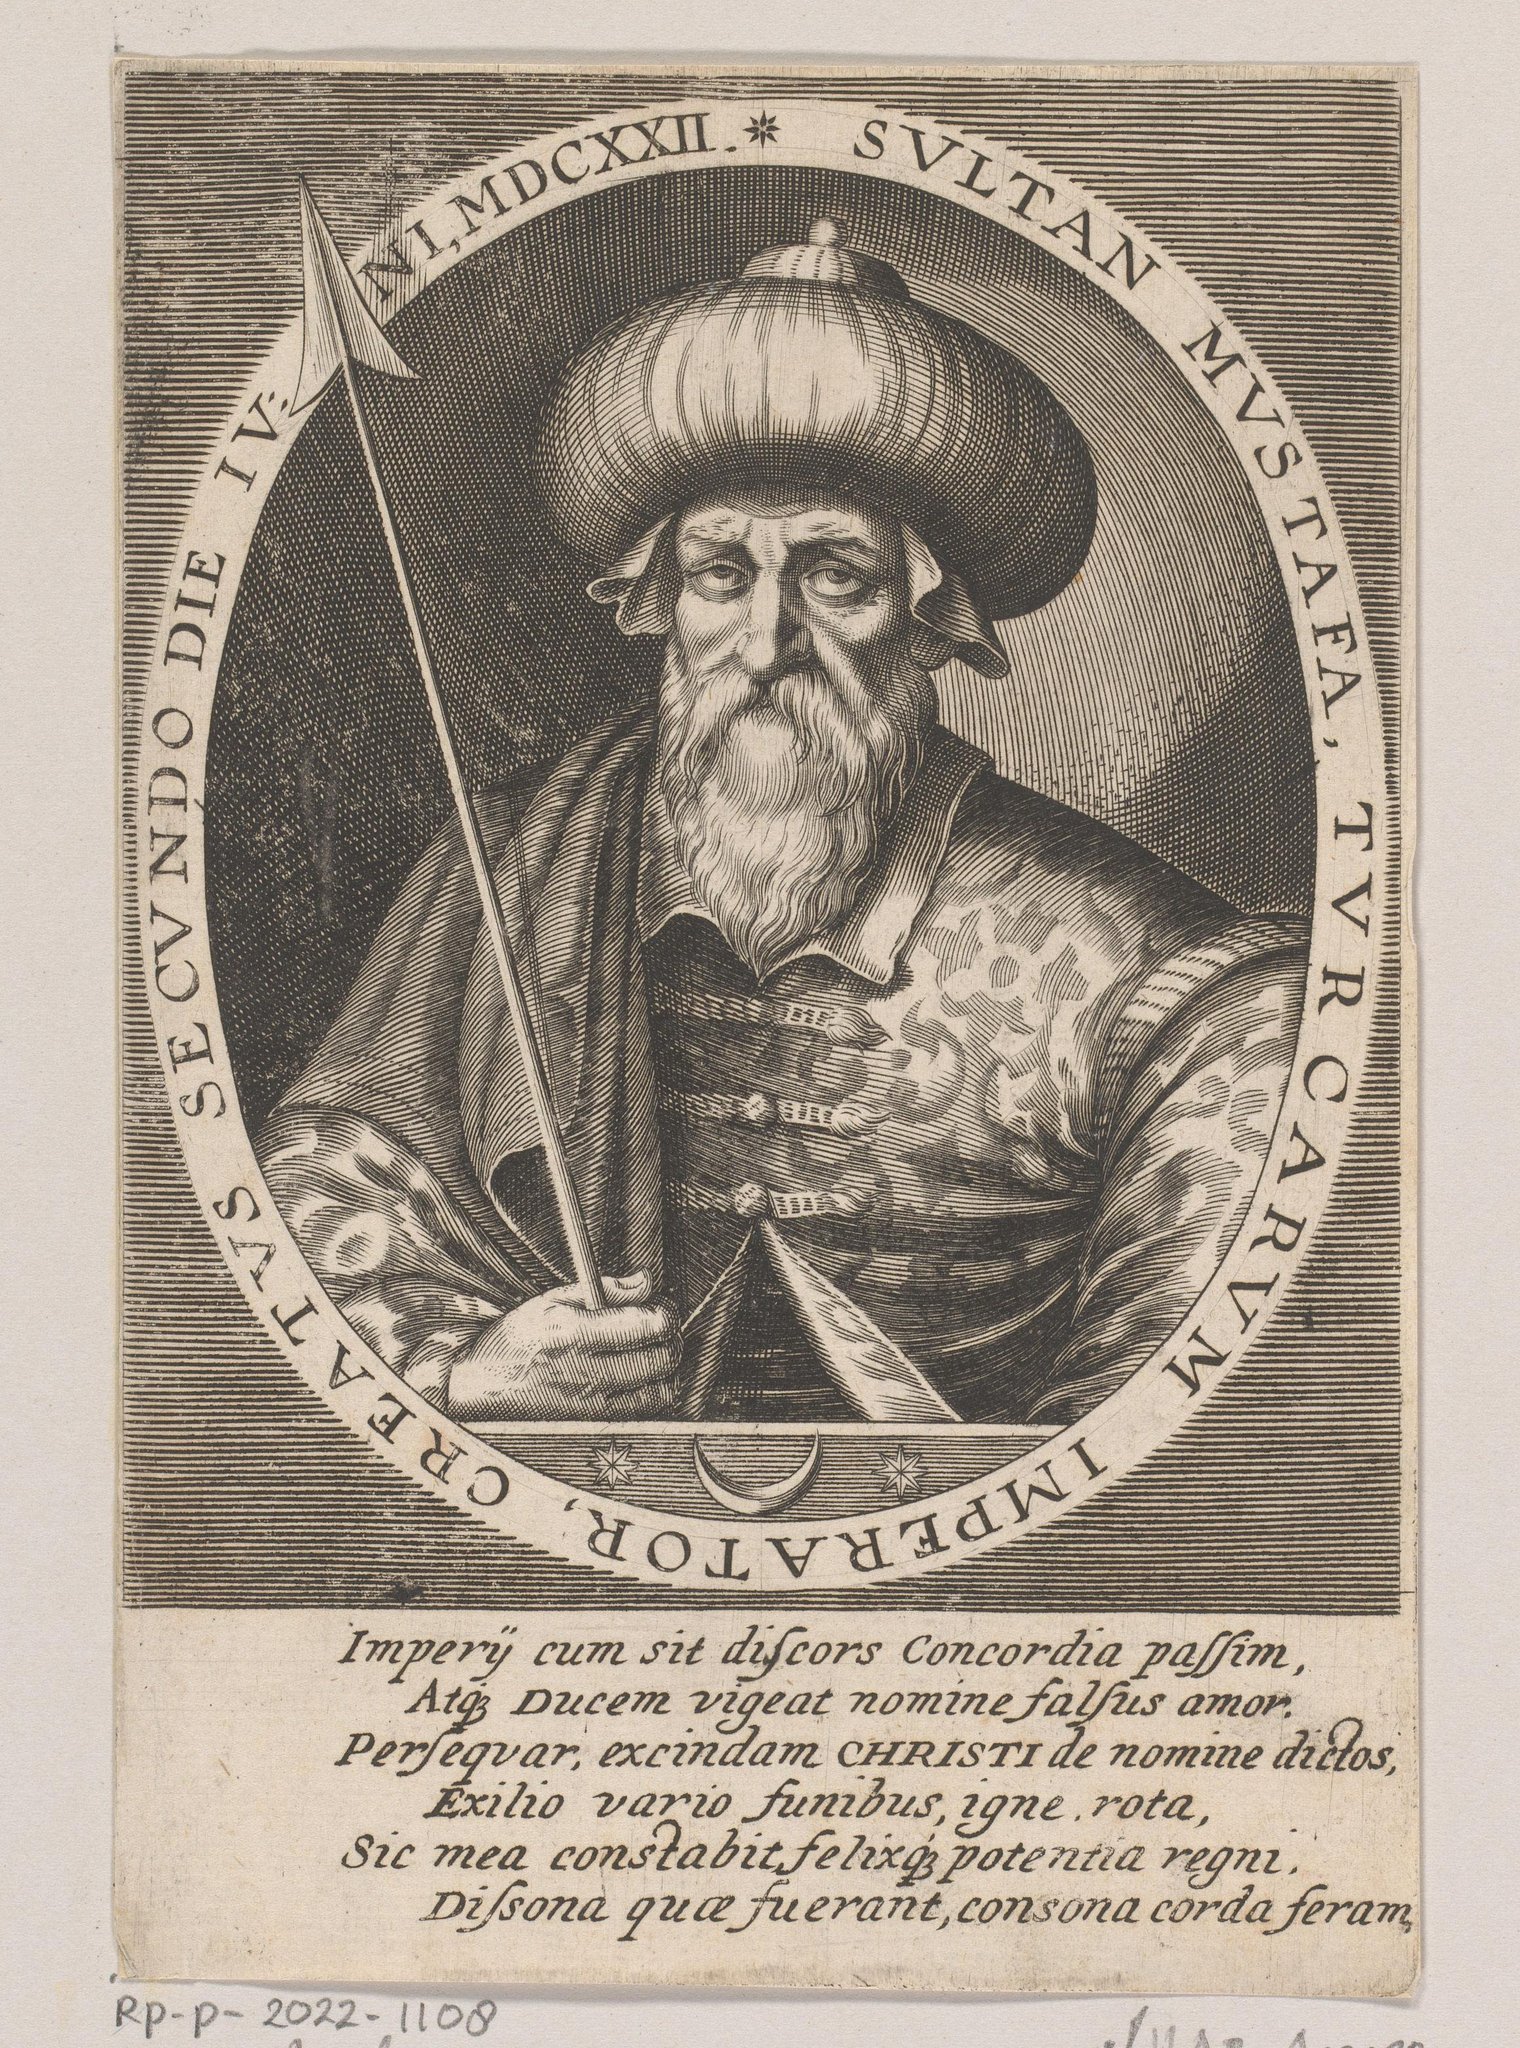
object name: print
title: Portret van Mustafa I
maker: Anonymous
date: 1622-1699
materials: paper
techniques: engraving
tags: historical persons, other sovereign (with title)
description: Met zesregelig onderschrift in het Latijn en tekst in het Latijn rondom het portret.